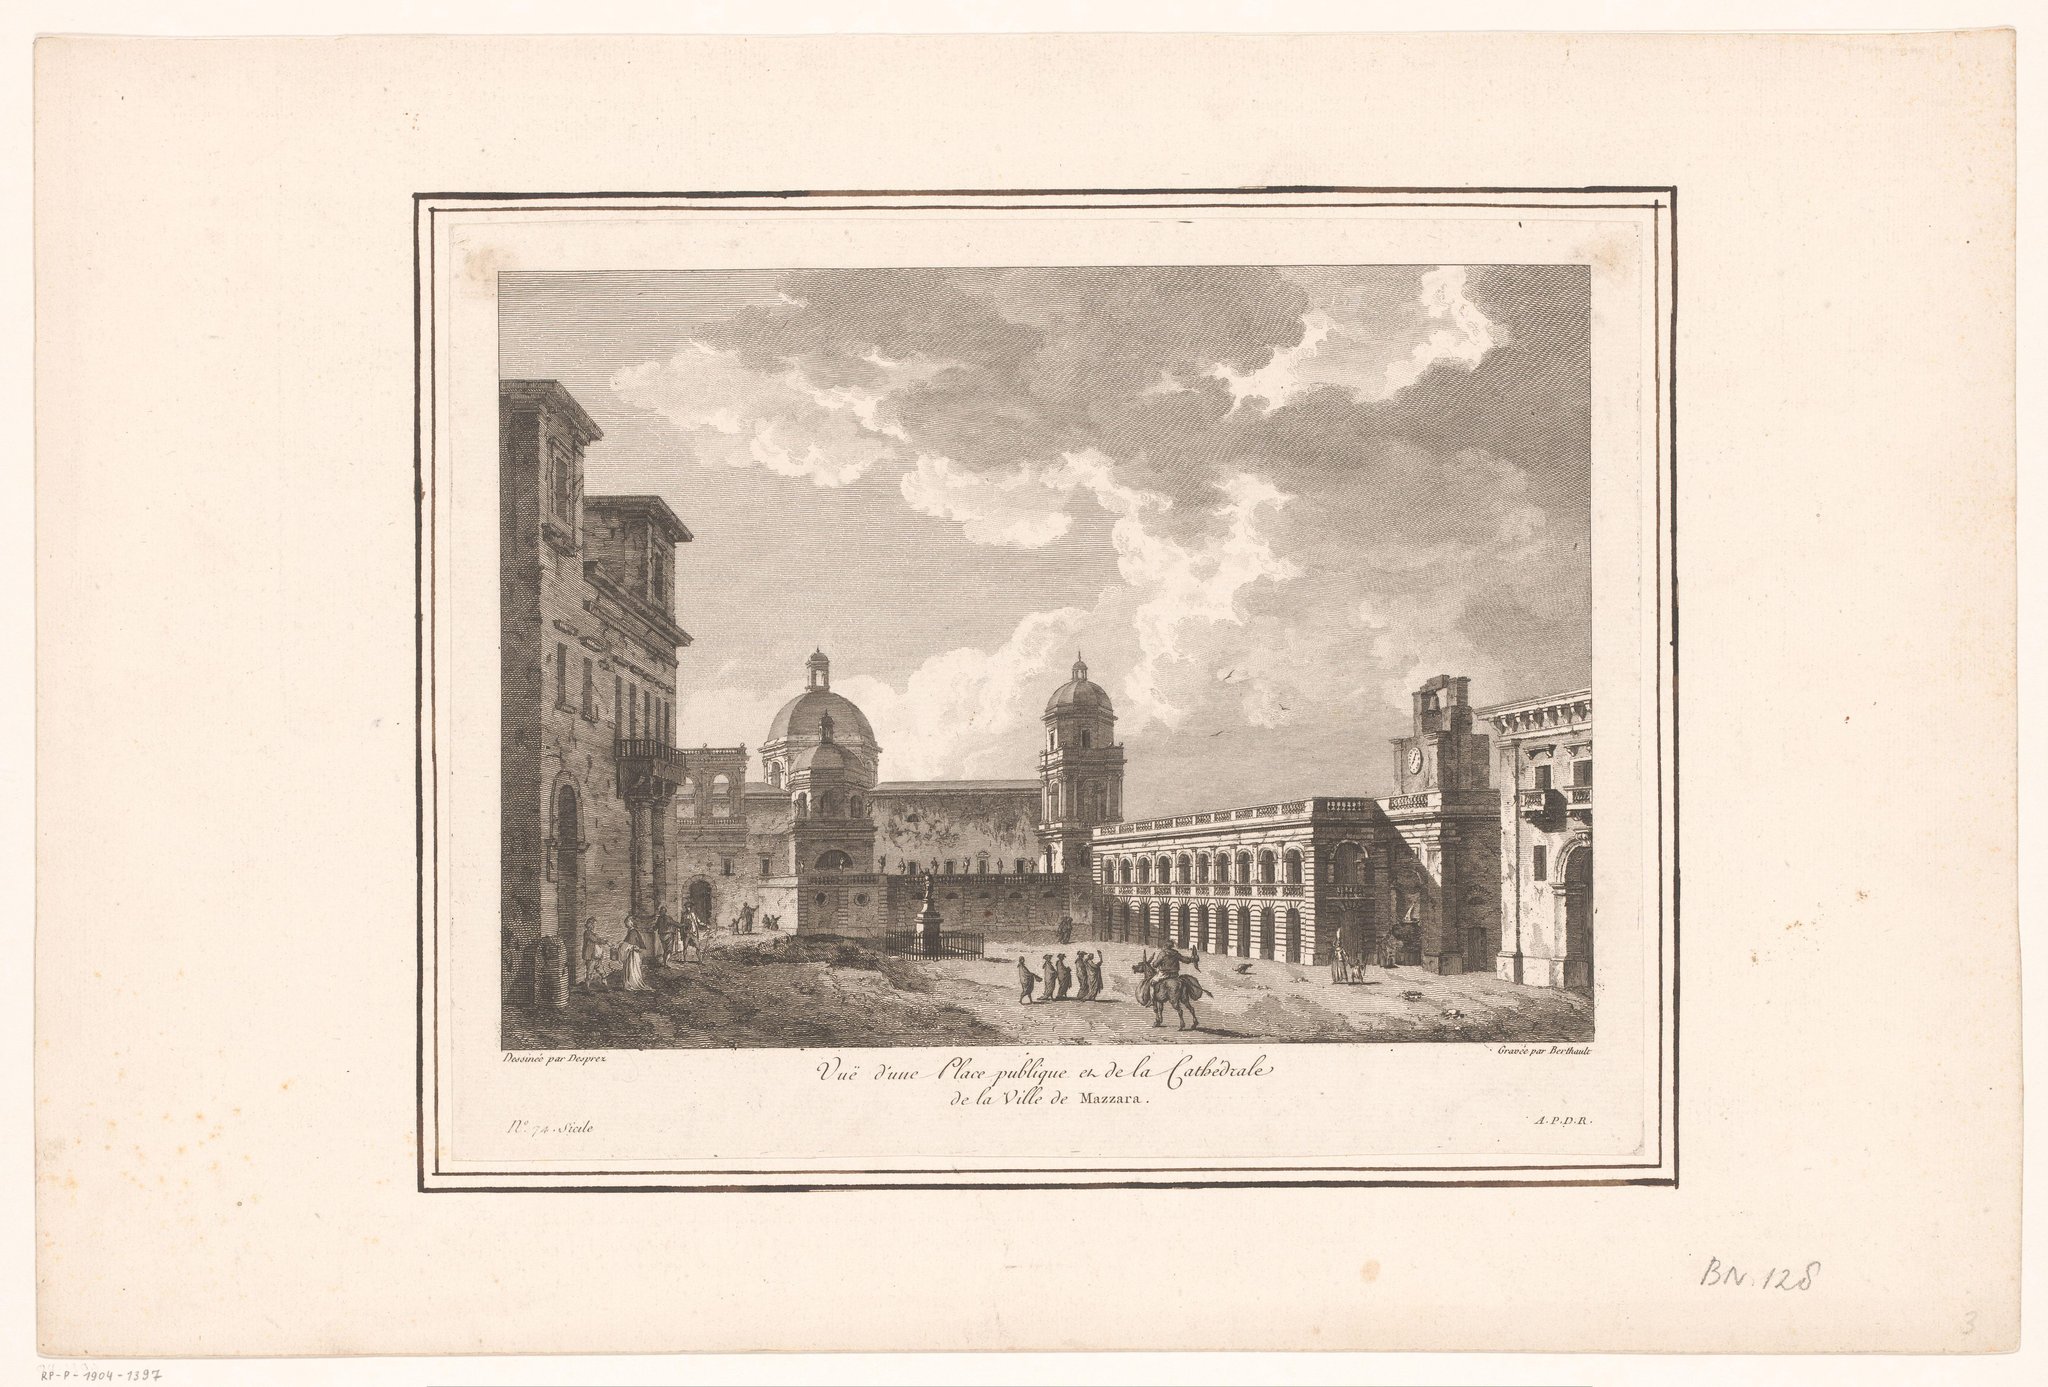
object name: print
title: Zicht op een plein in Mazzarò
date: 1753-1819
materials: paper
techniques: etching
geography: france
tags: riding a horse, ass, or mule; rider, horseman, village square, place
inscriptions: collector's mark: Lugt 2228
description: Linksonder genummerd №74. Op het opzetblad is op de verso een ets van Weigelij aangebracht.